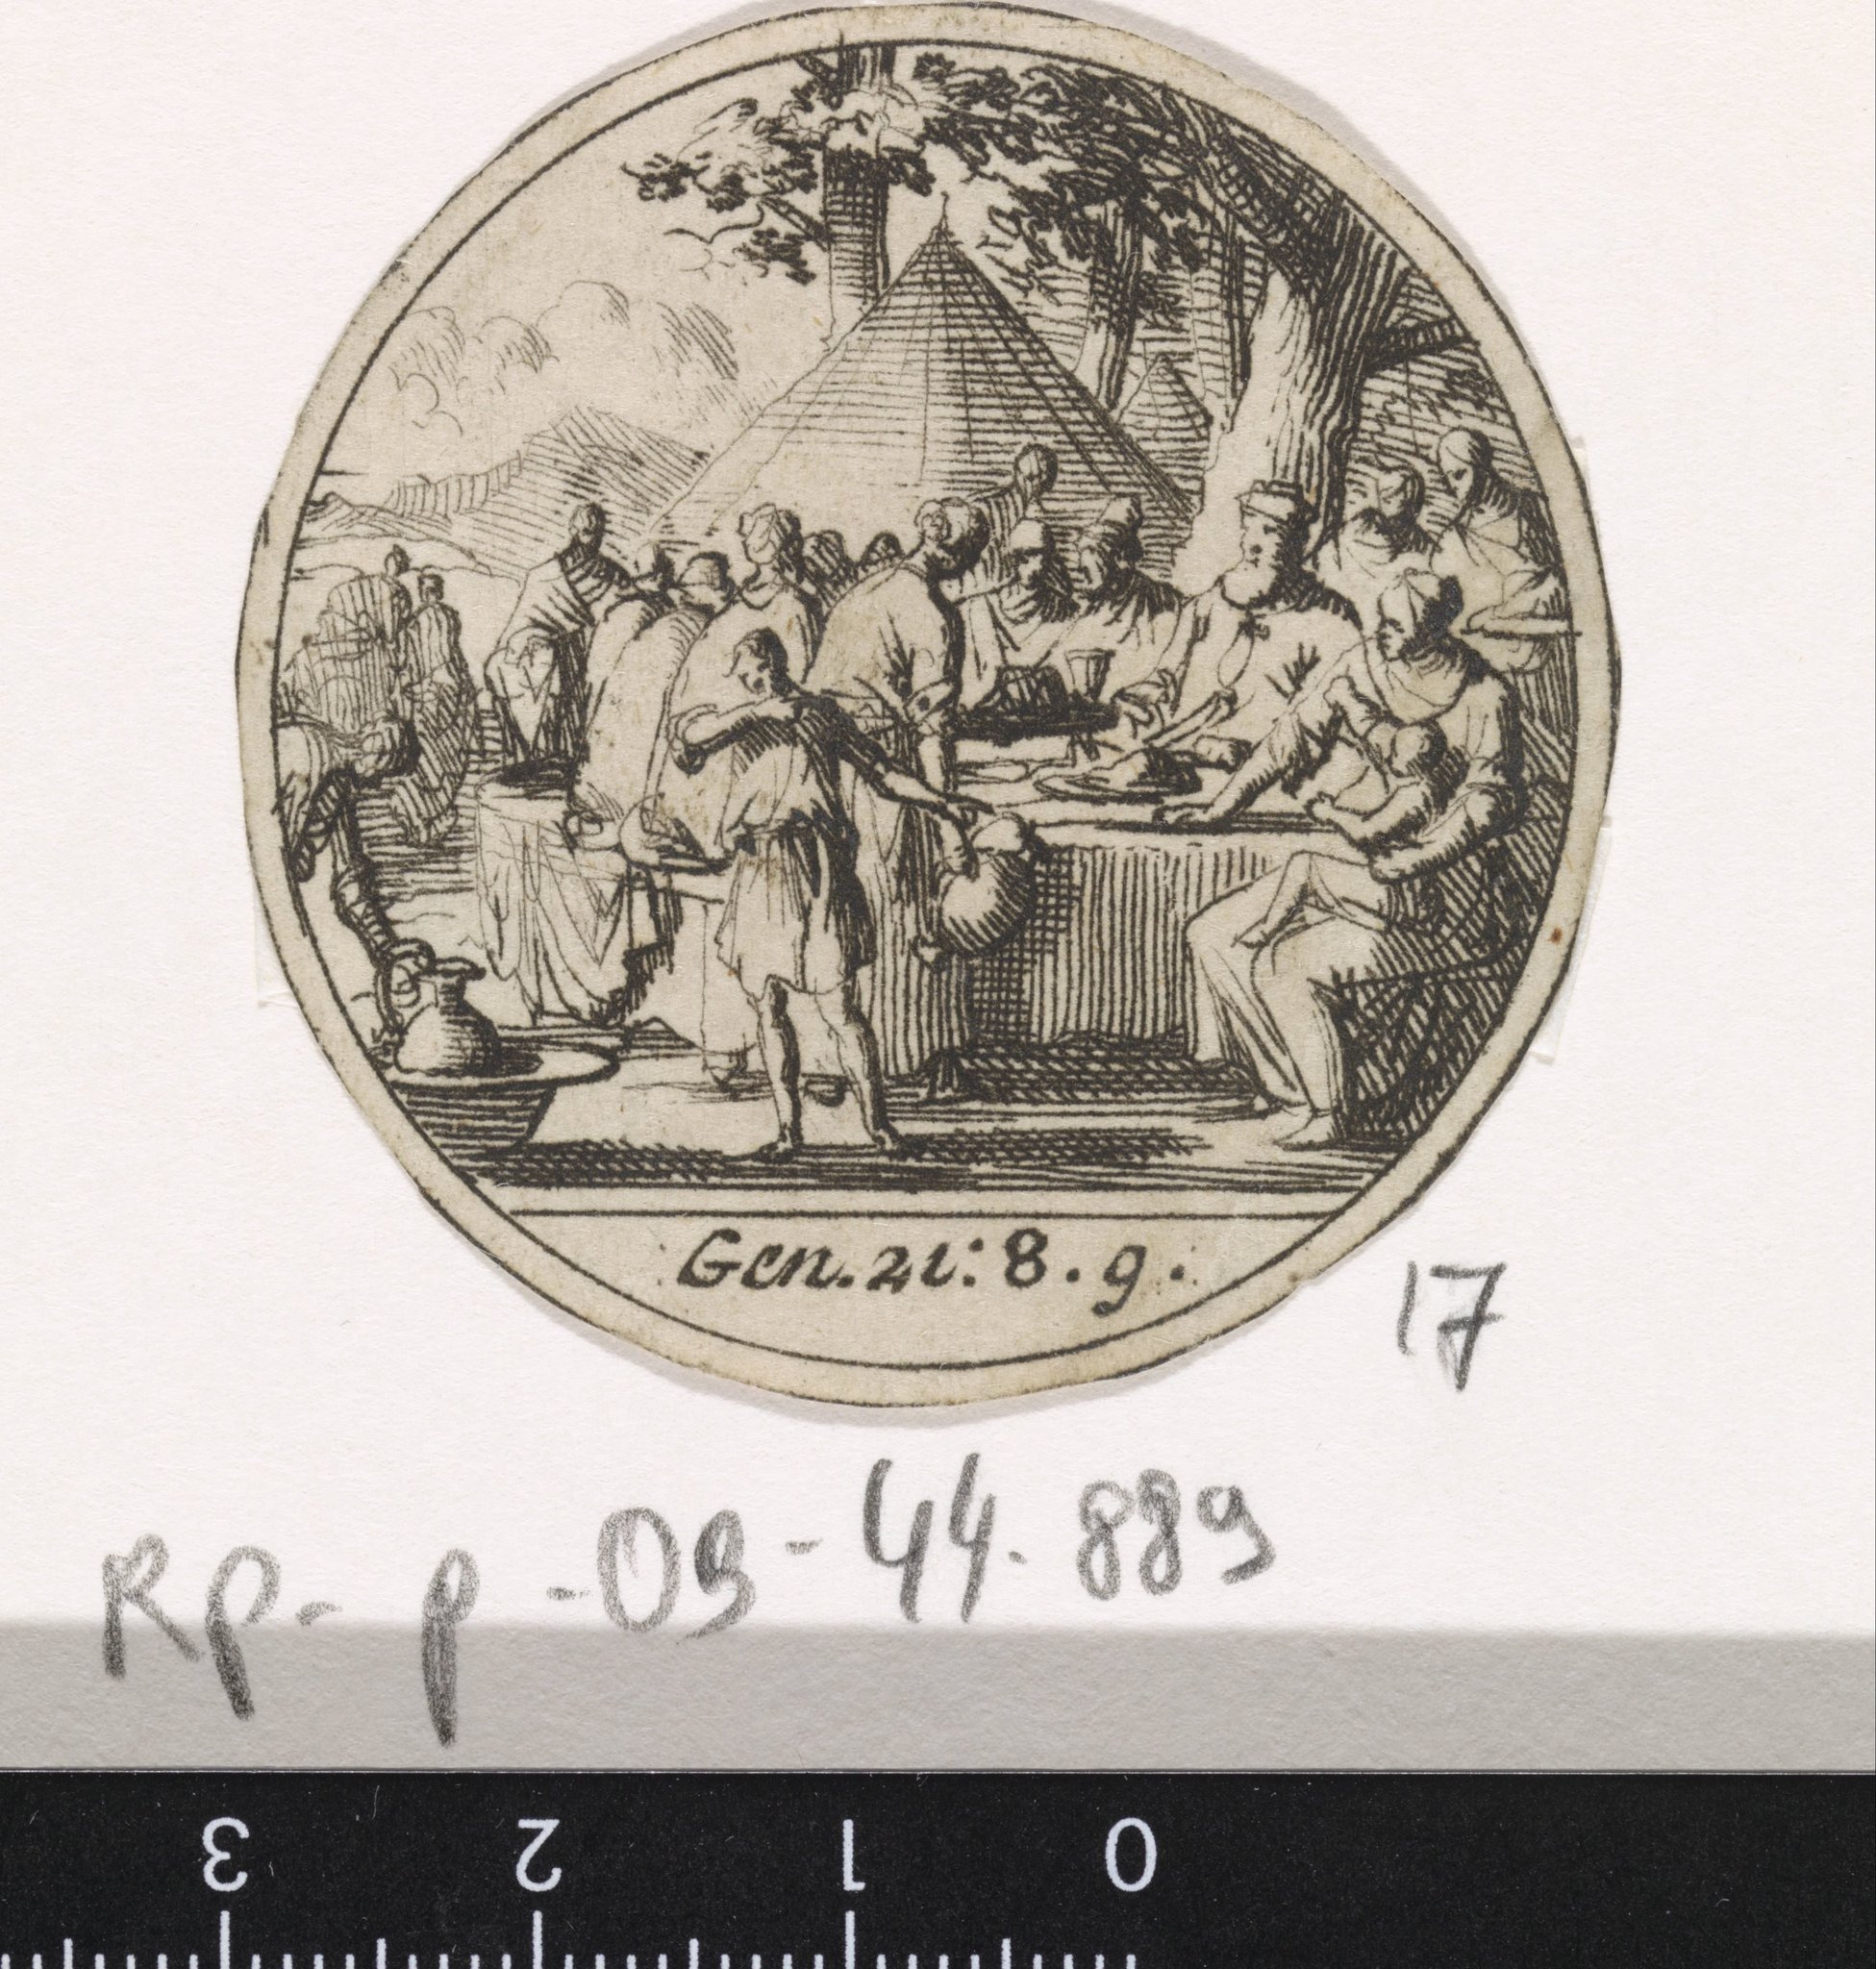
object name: book illustration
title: Ismaël bespot Isaak tijdens het besnijdenisfeest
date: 1700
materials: paper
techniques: etching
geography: amsterdam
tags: abraham's feast on the day of isaac's weaning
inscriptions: collector's mark: Lugt 240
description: Boekillustratie voor Willem Goeree. Mosaize historie der Hebreeuwse kerke. Amsterdam: Willem & David Goeree, 1700.